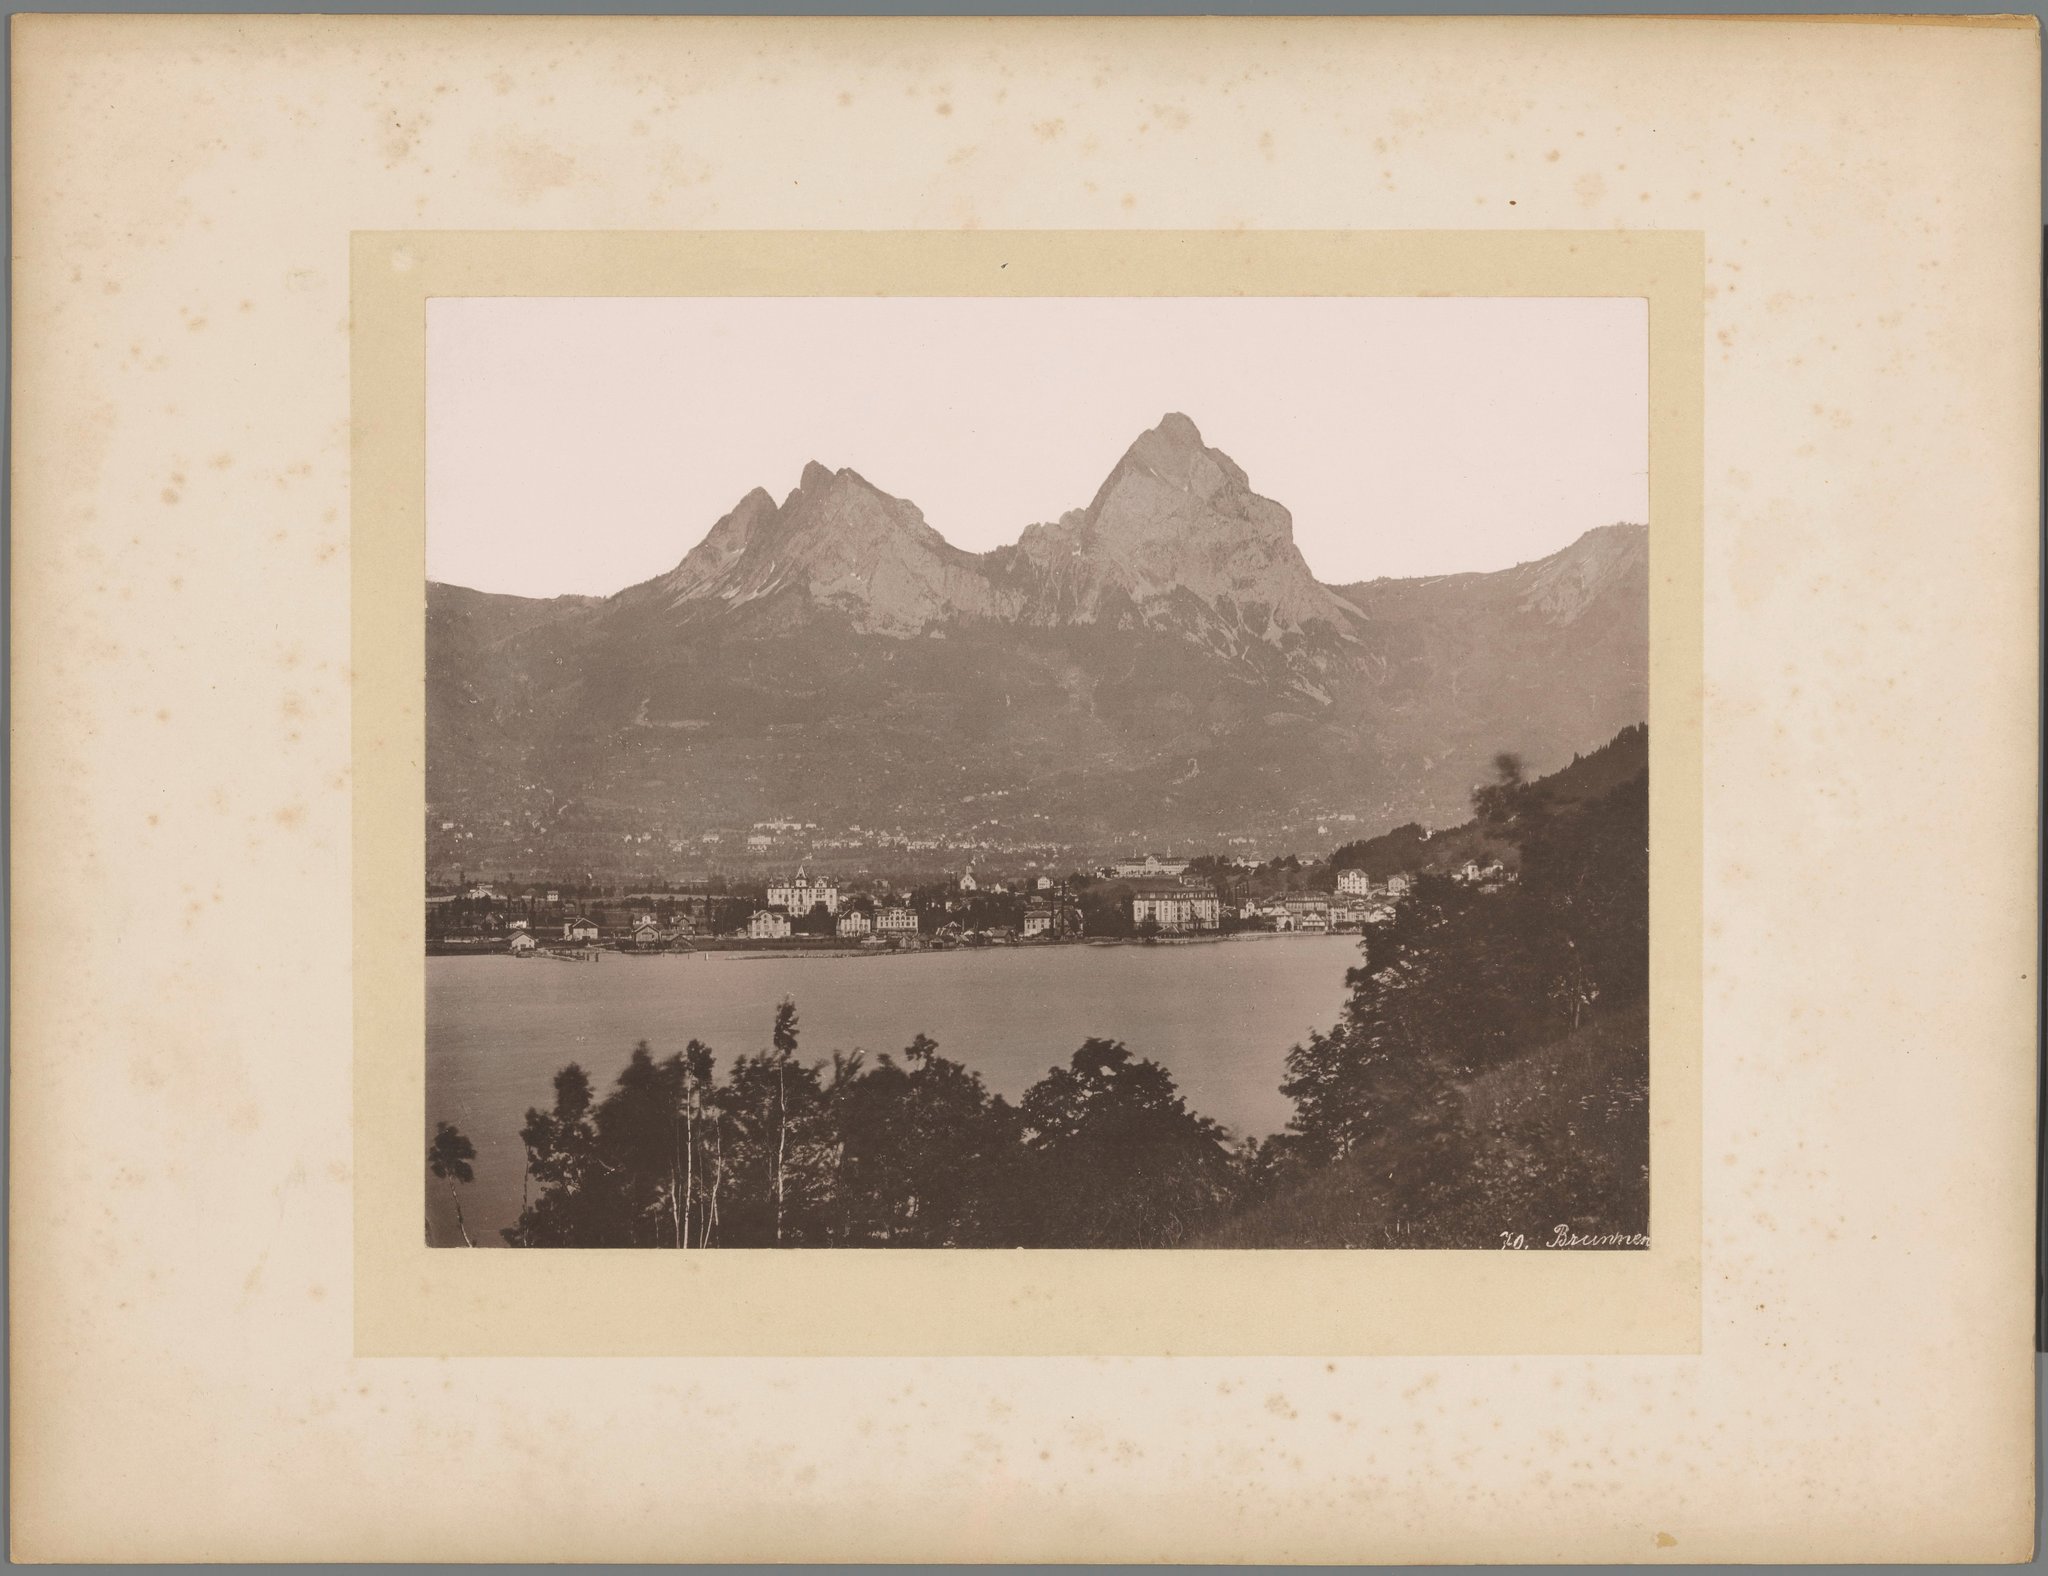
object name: photomechanical print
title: Gezicht op Brunnen aan het Vierwoudstrekenmeer in Zwitserland, op de achtergrond de Grosser en Kleiner Mythen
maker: Anonymous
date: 1870-1930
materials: cardboard, paper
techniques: photograph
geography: brunnen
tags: city-view in general; 'veduta', lake, mountains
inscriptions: number: ‘70. [?]’